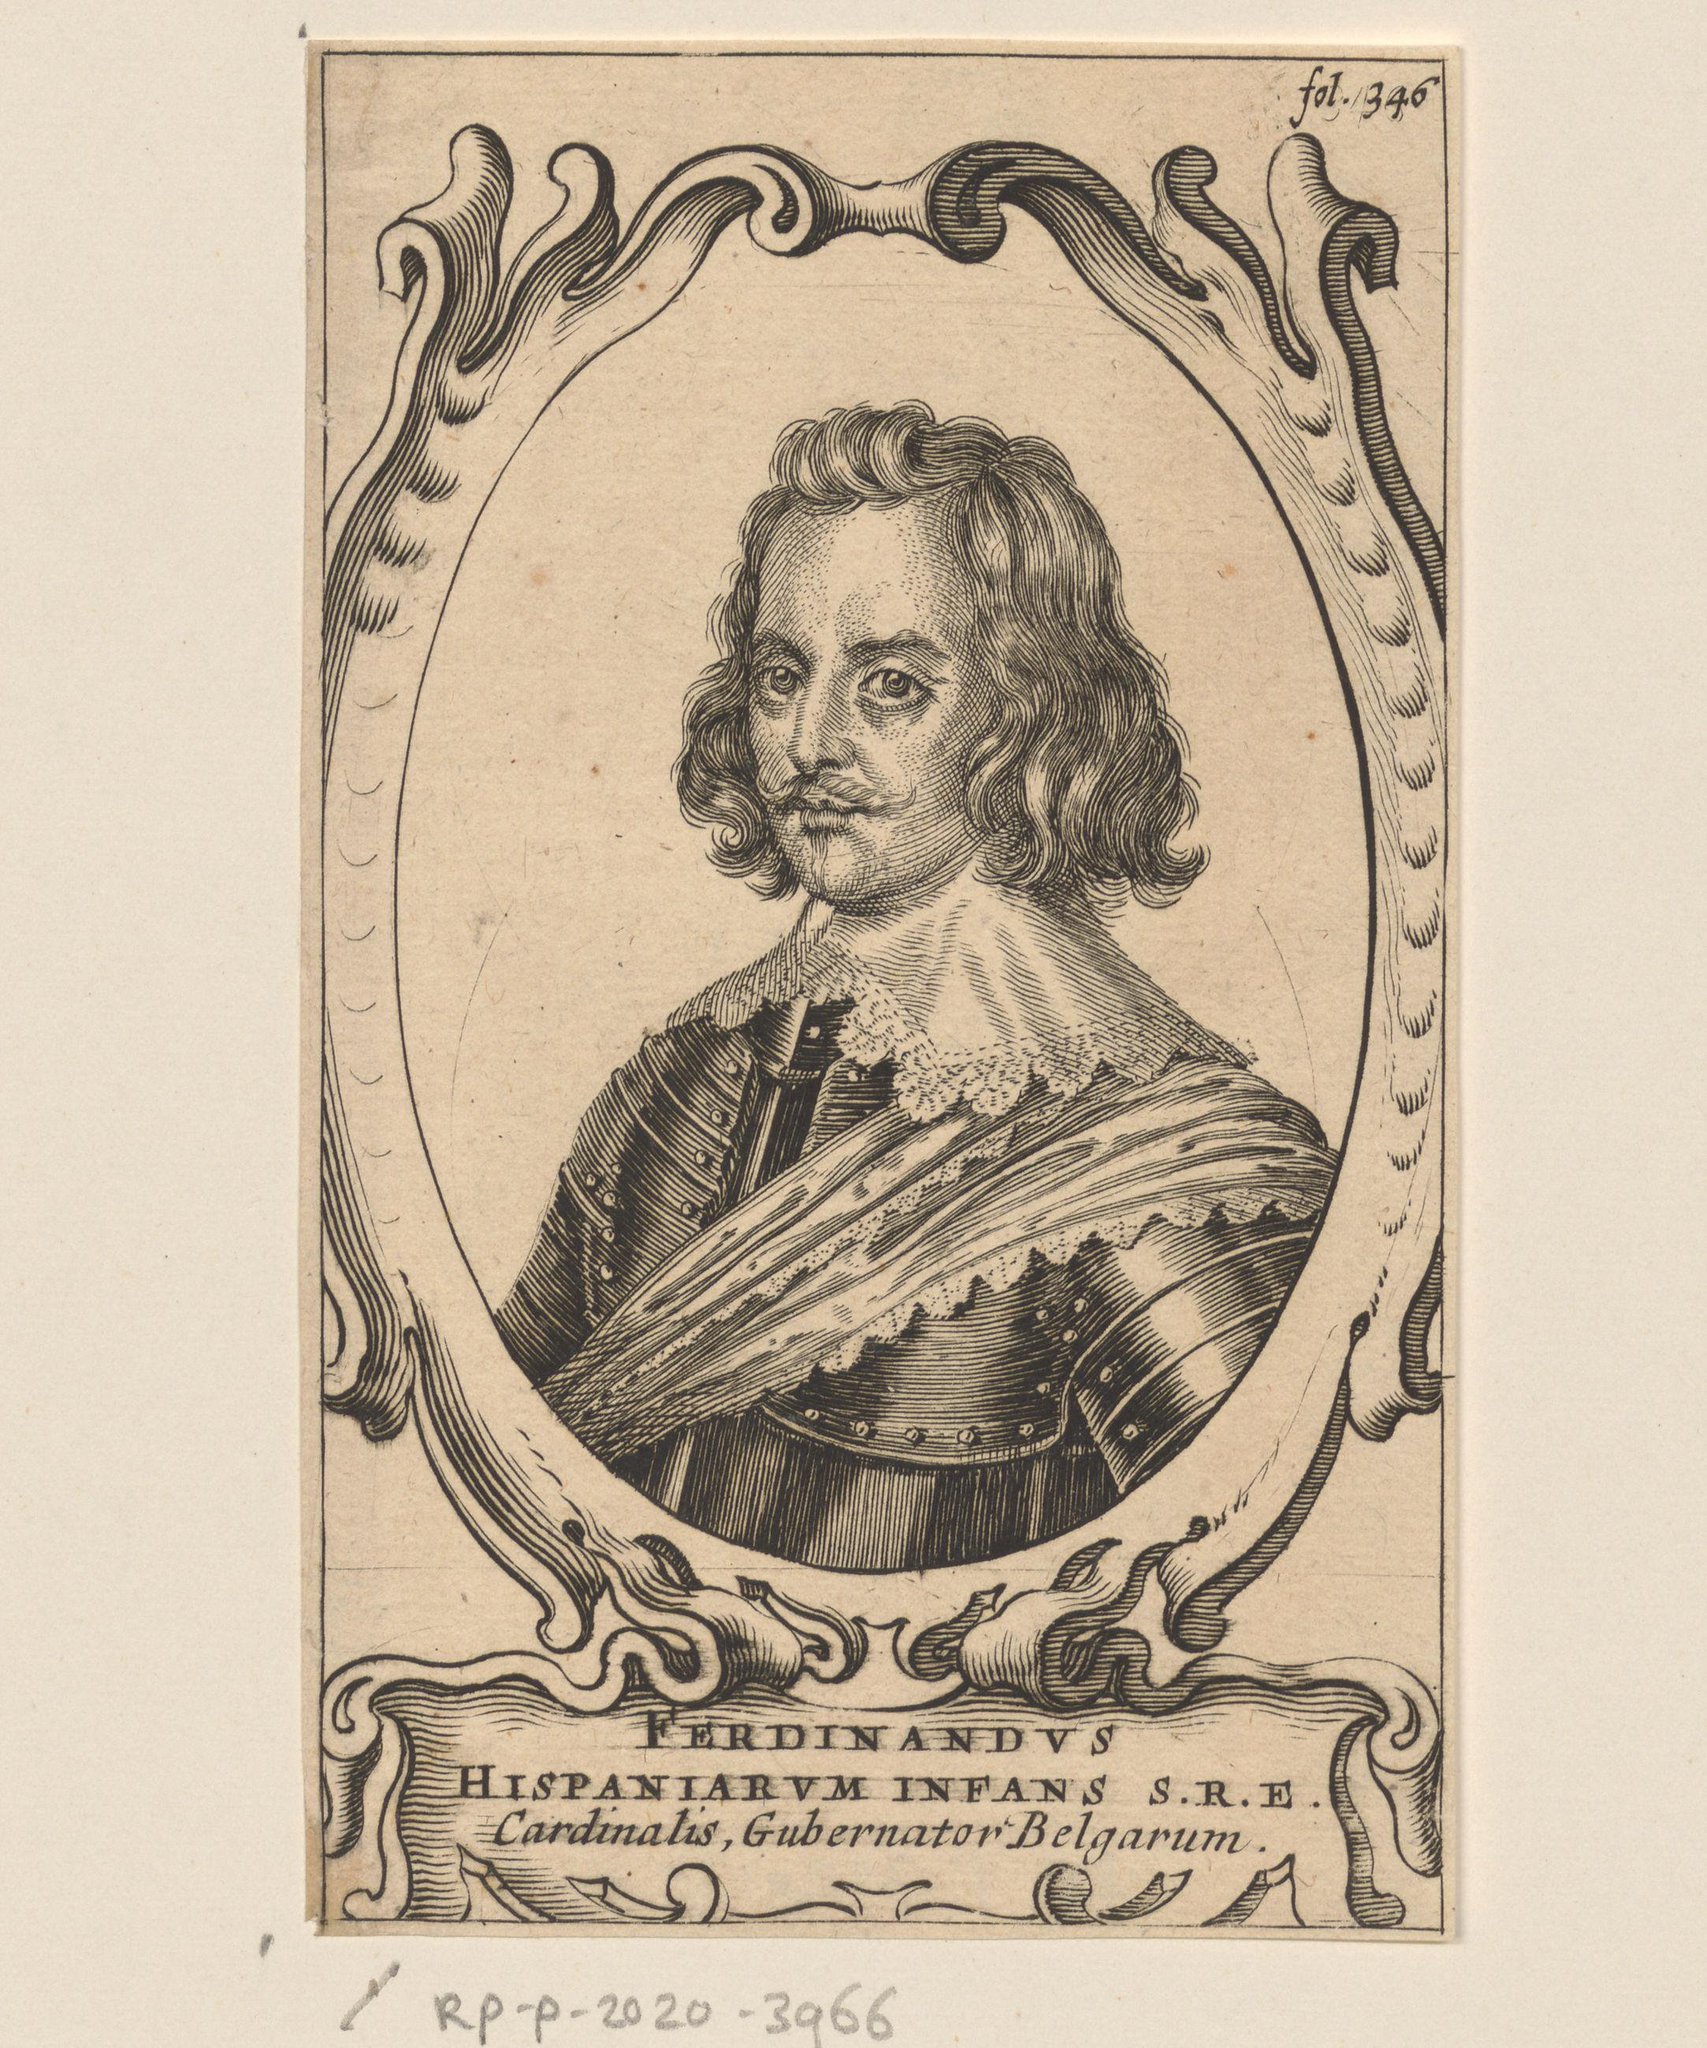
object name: book illustration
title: Portret van Ferdinand van Oostenrijk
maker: Anonymous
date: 1656-1666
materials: paper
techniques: engraving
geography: northern netherlands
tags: brussels, landvoogd der zuidelijke nederlanden ferdinand van oostenrijk, historical persons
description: Prent waarschijnlijk uit: Brachelius, Johannes Adolphus. Historia nostri temporis, dat is geschiedenis onses tijts (…). Rotterdam: Andries van Hoogenhuysen, 1656. Prent ook gebruikt in de 1659- en 1666-editie.